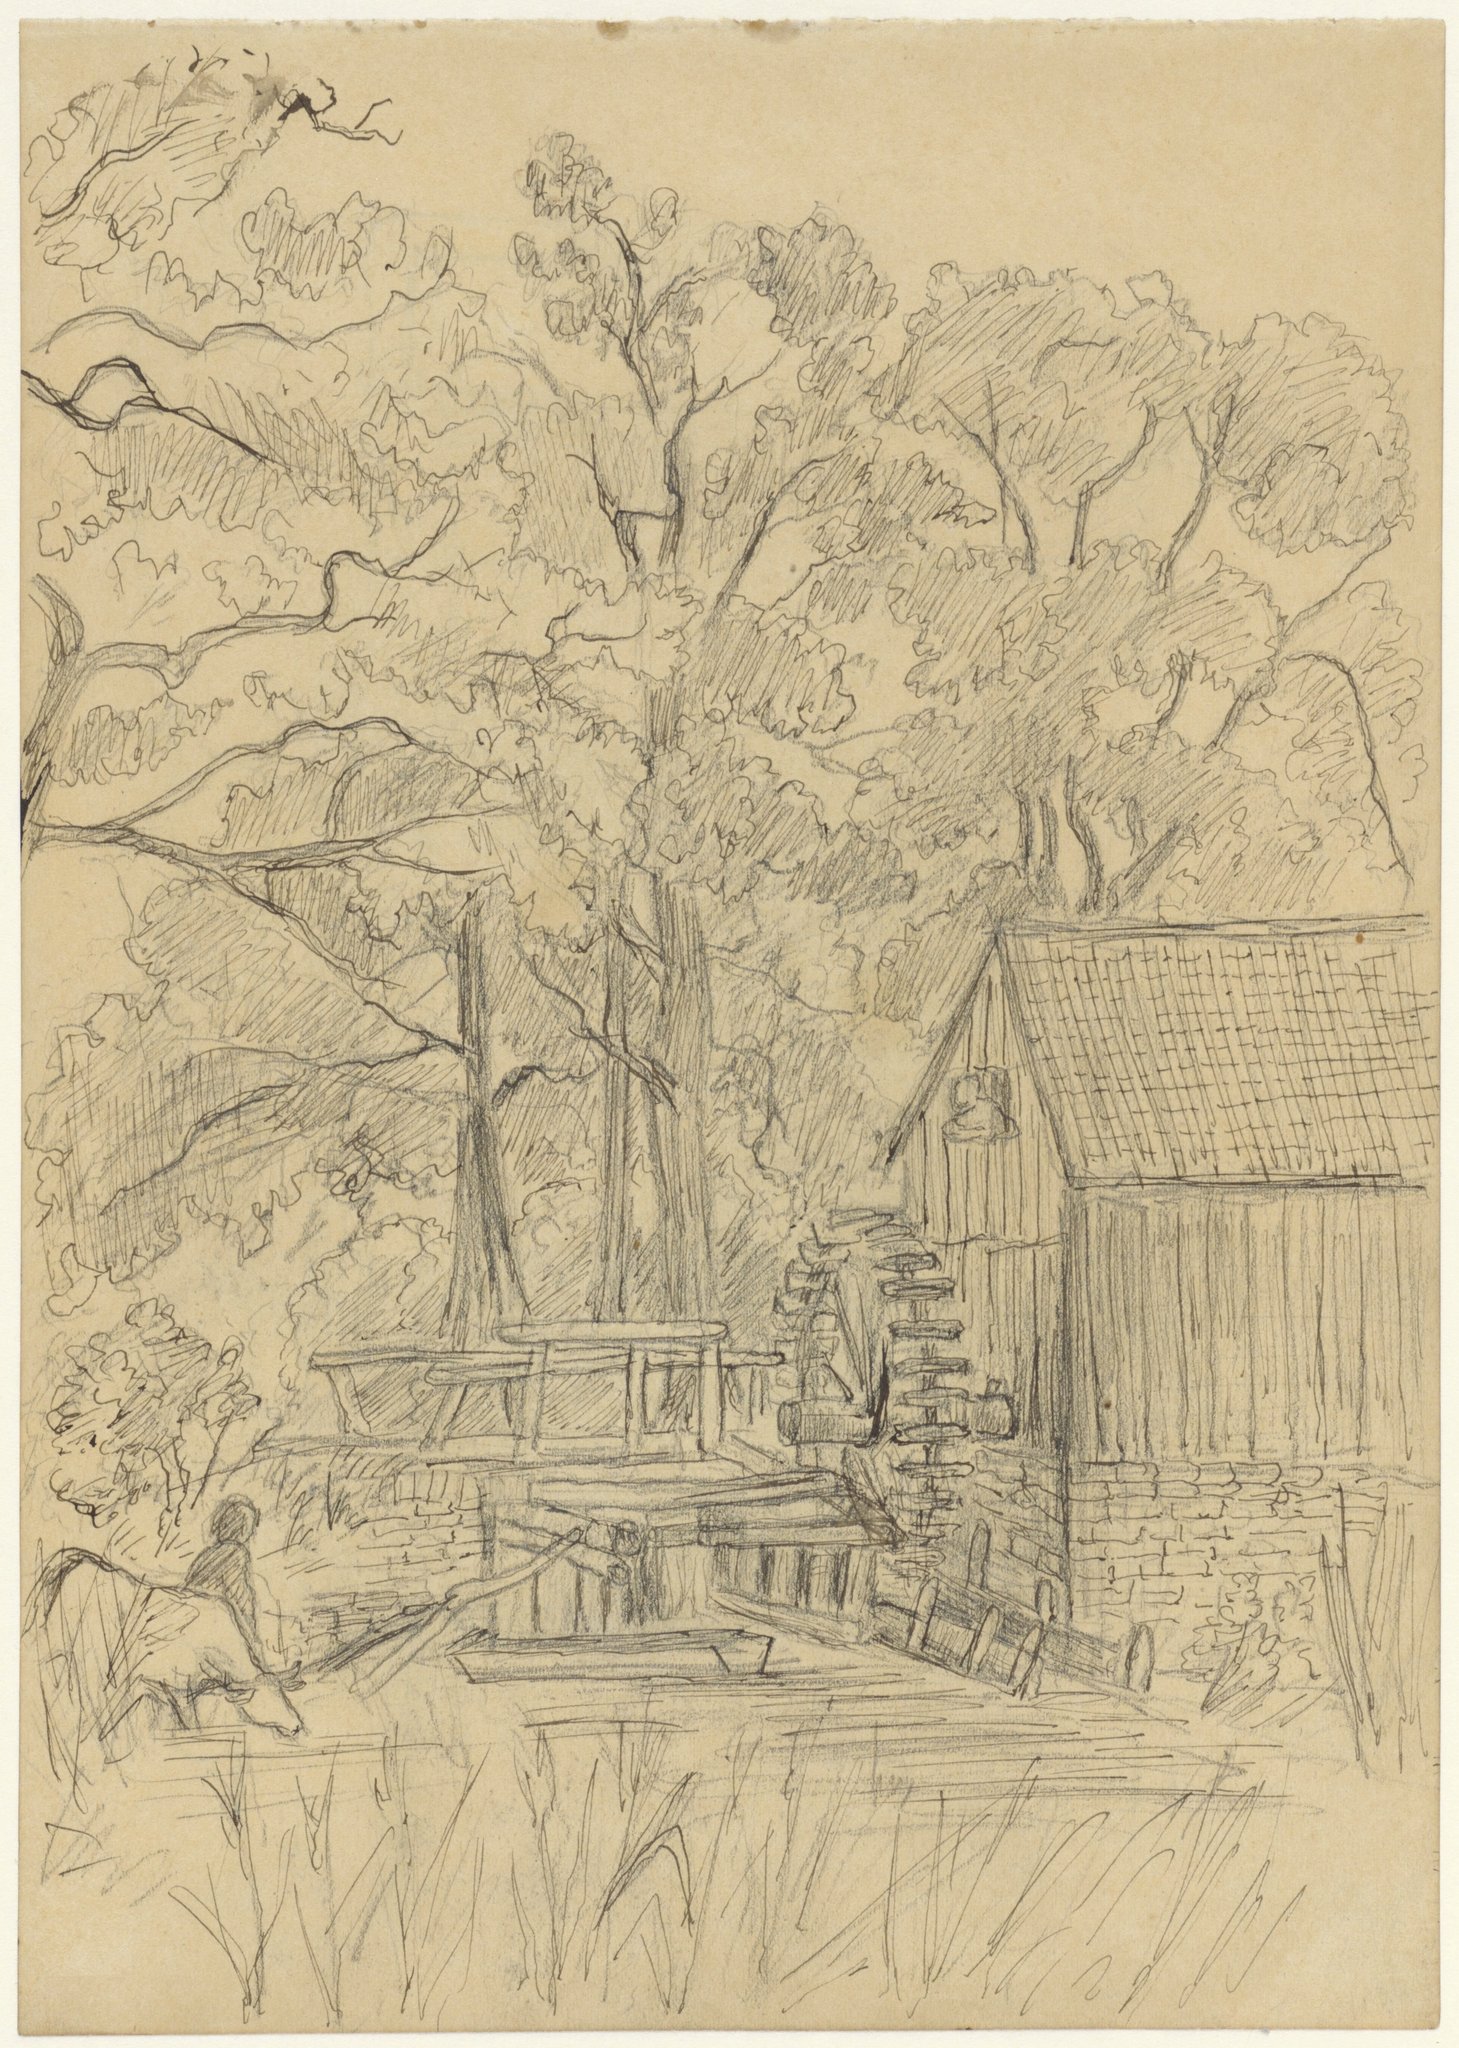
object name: drawing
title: Watermolen tussen bomen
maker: jozef israëls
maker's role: draughtsman, painter, print maker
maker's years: 1824-1911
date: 1834-1911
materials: ink, paper, pencil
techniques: pen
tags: watermill